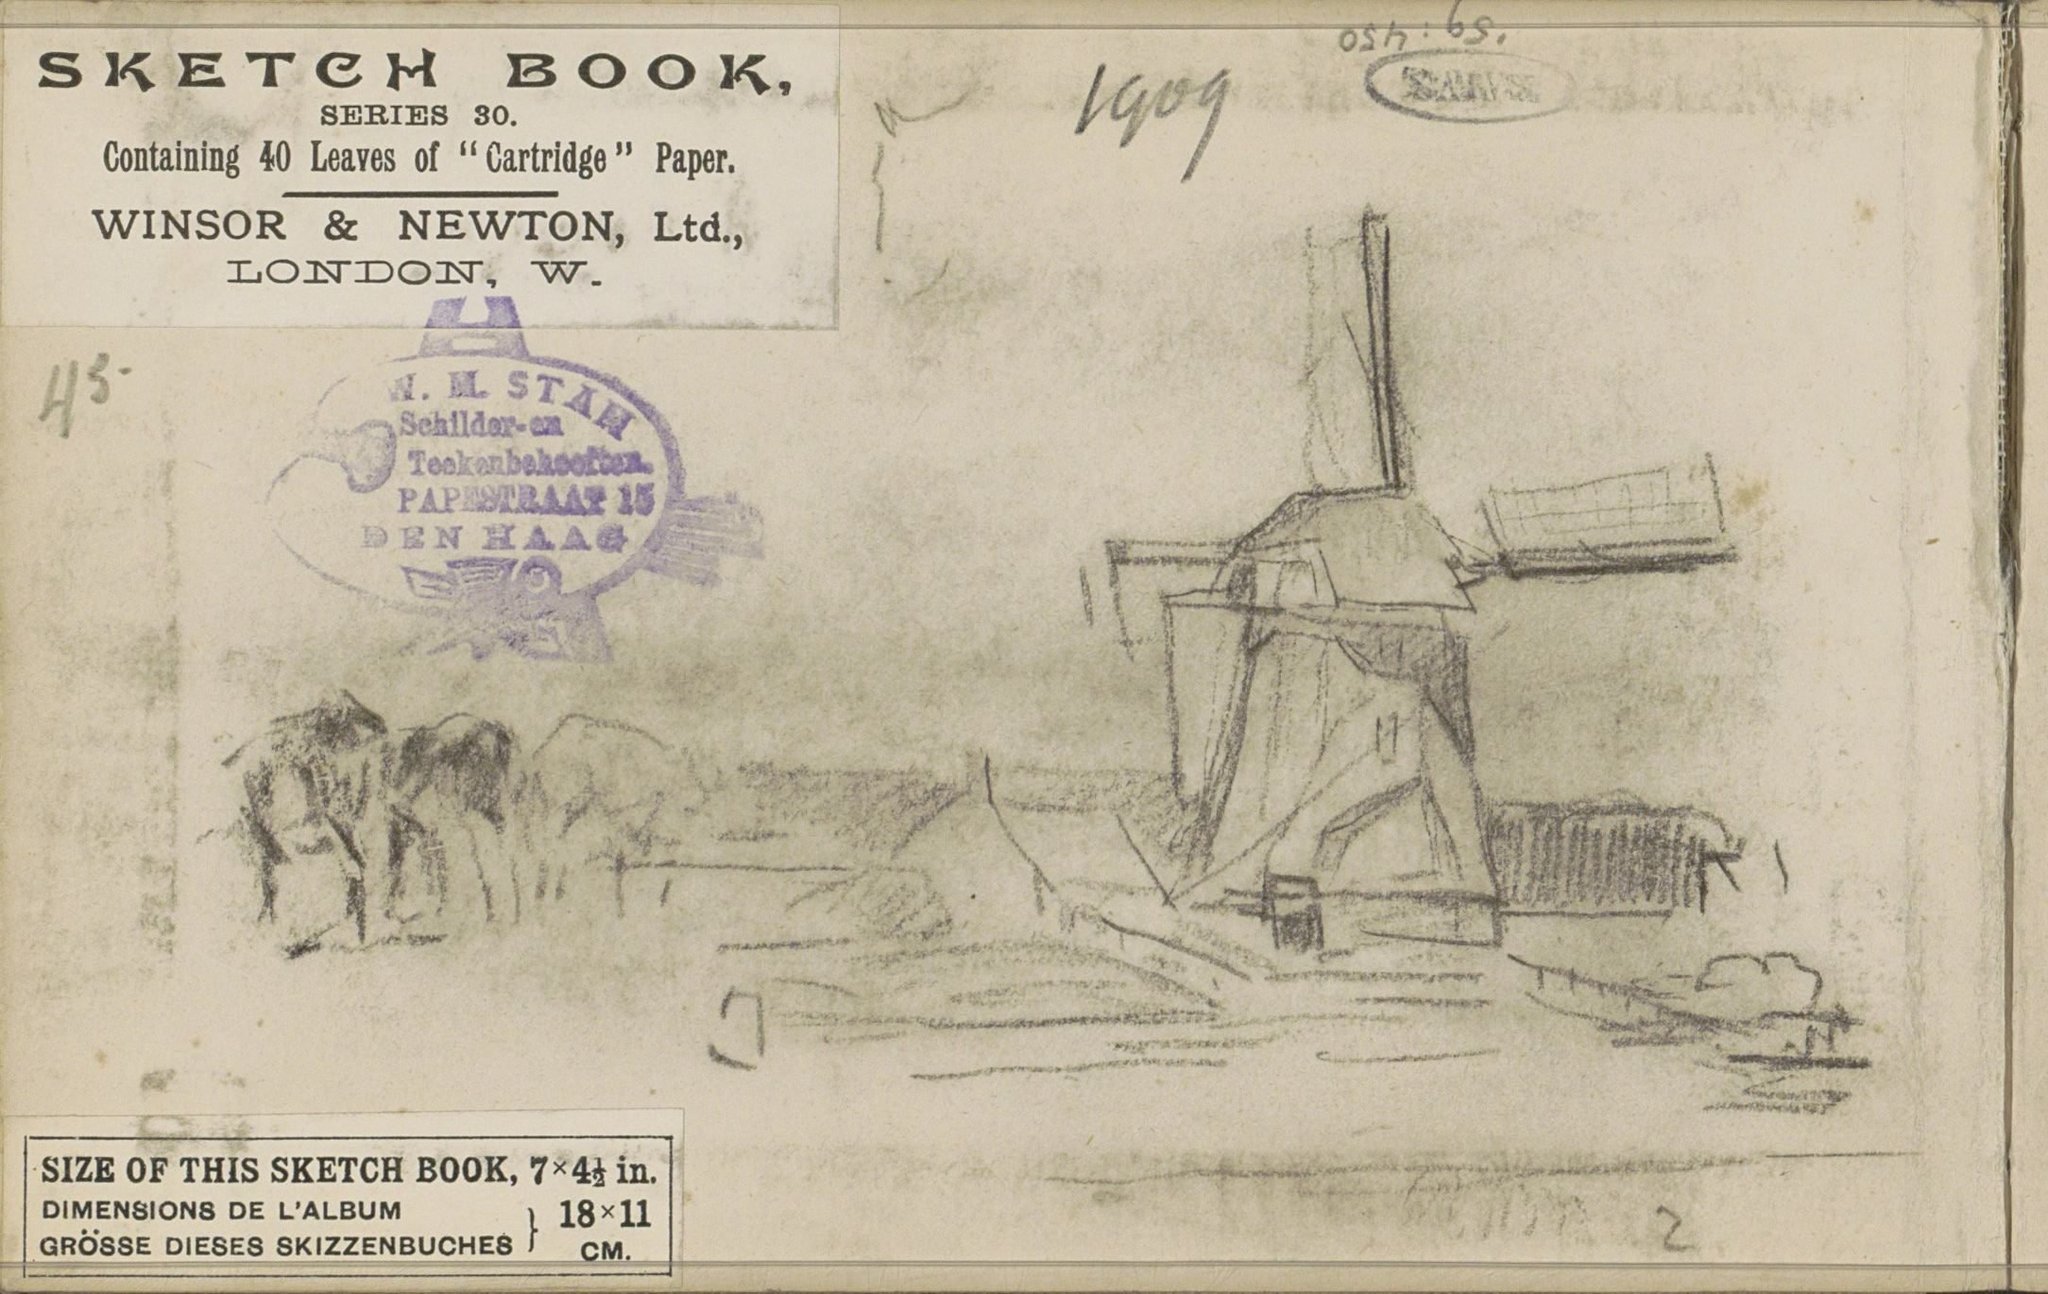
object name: sketchbook leaf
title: Vee en dorpsgezicht met een molen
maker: johan antonie de jonge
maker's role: draughtsman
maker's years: 1864-1927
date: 1909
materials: chalk, paper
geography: south holland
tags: cow, windmill in landscape (+ city(-scape) with figures, staffage)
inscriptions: date: ‘1909’, label: ‘Size of this sketch book, 7 x 4 1/2 in./ Dimensions de l'album/ Grösse dieses Skizzenbuches/ 18 x 11 cm.’, collector's mark: Lugt 2228, factory mark: ‘Sketch book,/ series 30./ Containing 40 Leaves of "Cartridge" Paper./ Winsor & Newton, Ltd.,/ London, W.’, retailer's mark: ‘W.M. Stam/ Schilder- en/ Teekenbehoeften./ Papestraat 15/ Den Haag’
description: Links vee, mogelijk koeien, van achteren gezien. Rechts een dorpsgezicht met een molen. Voorste schutblad uit een schetsboek met 31 bladen.